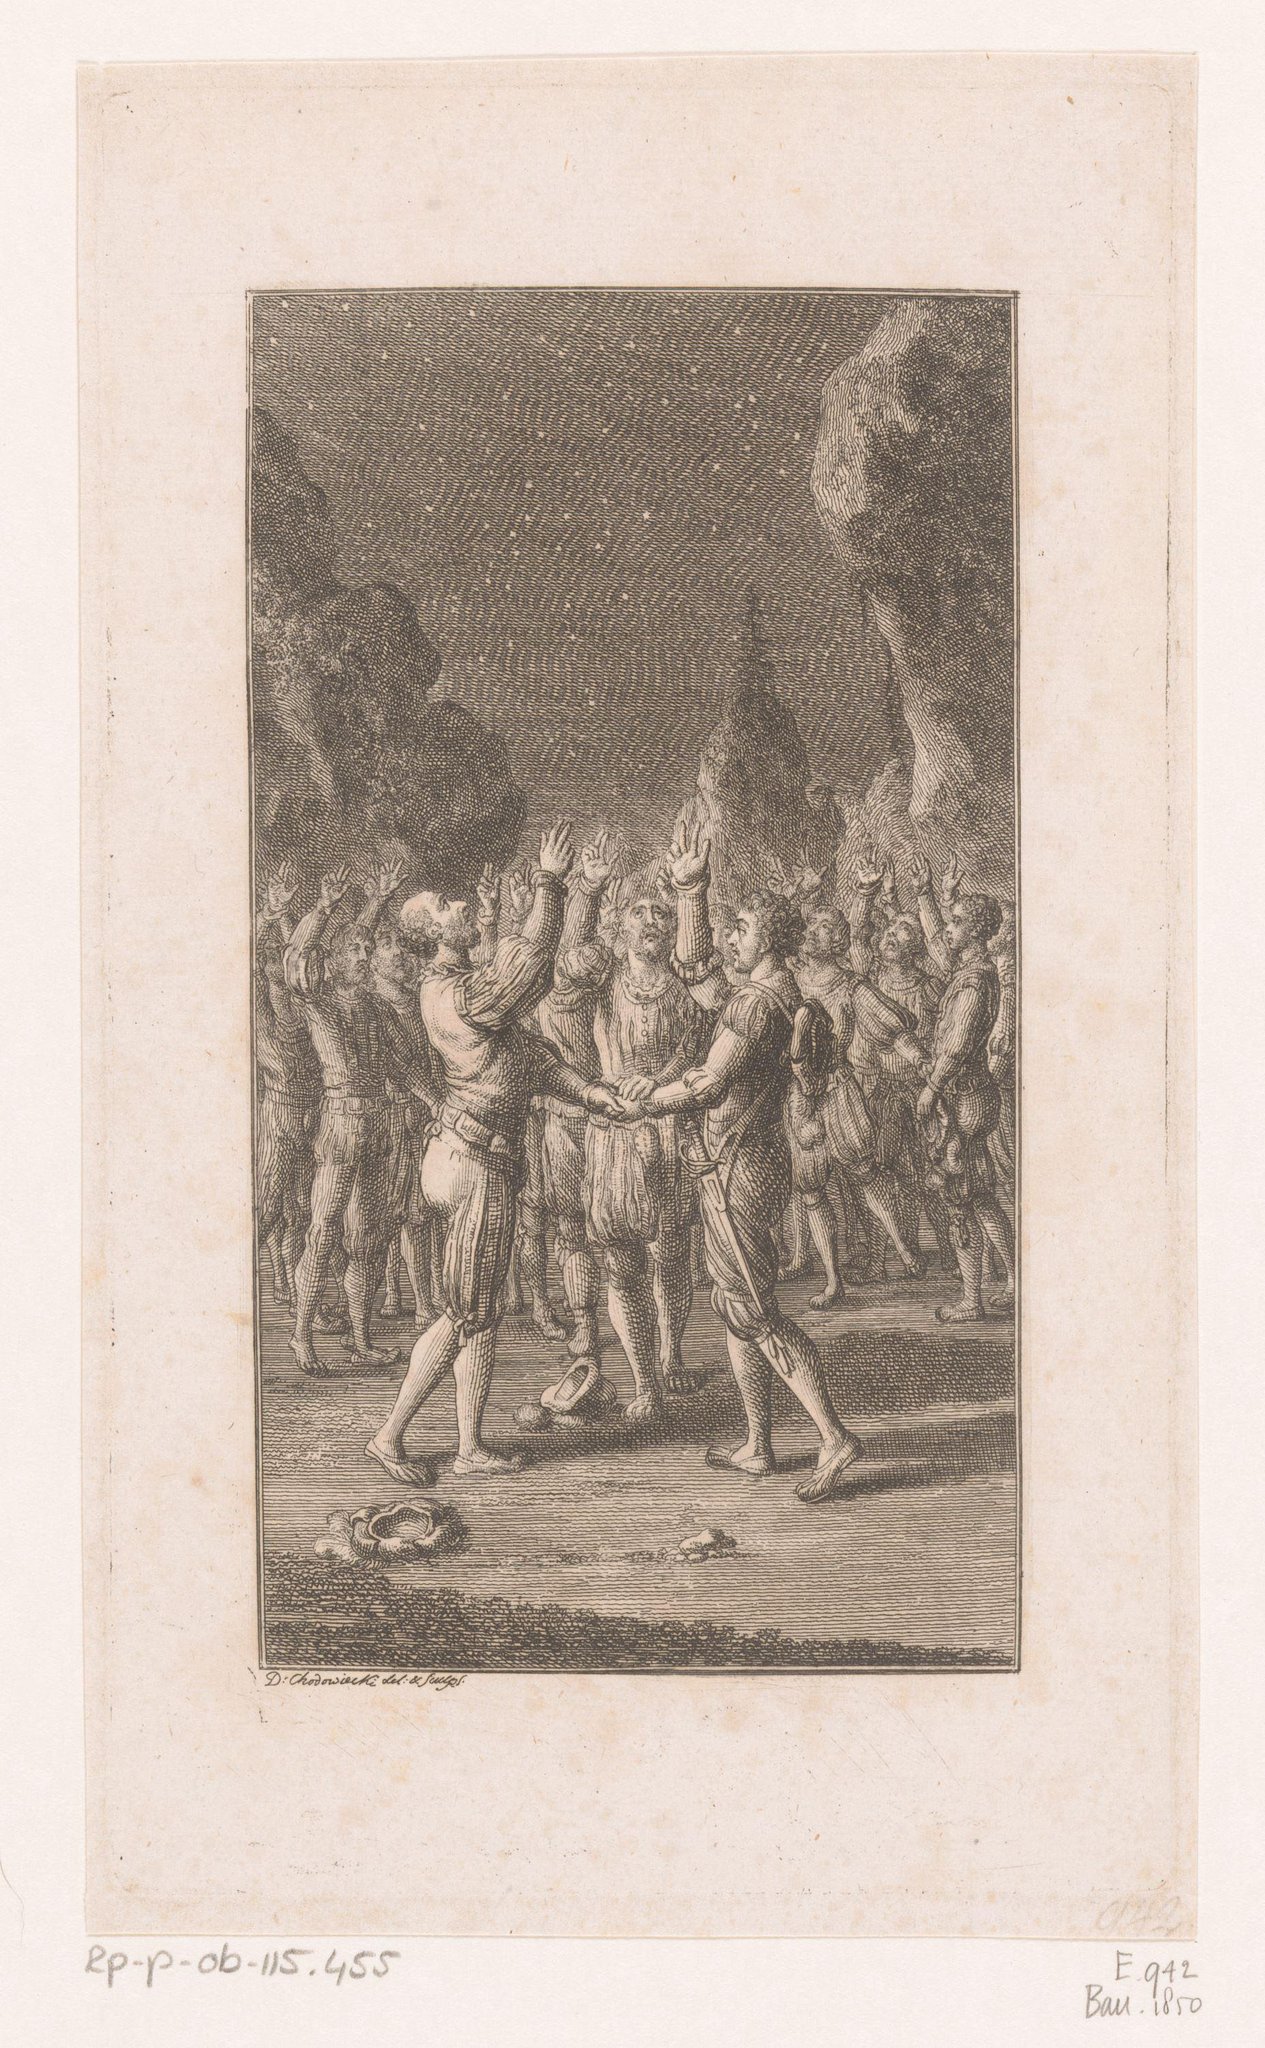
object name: print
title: Mannen leggen een eed af onder de sterrenhemel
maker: daniel nikolaus chodowiecki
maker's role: draughtsman, print maker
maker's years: 1726-1801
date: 1800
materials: paper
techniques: etching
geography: berlin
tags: history, oath, stars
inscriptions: collector's mark: Lugt 2228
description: Prent gebruikt voor: Deutsche Monatsschrift (...). Leipzig: Sommersche Buchhandlung, 1800.